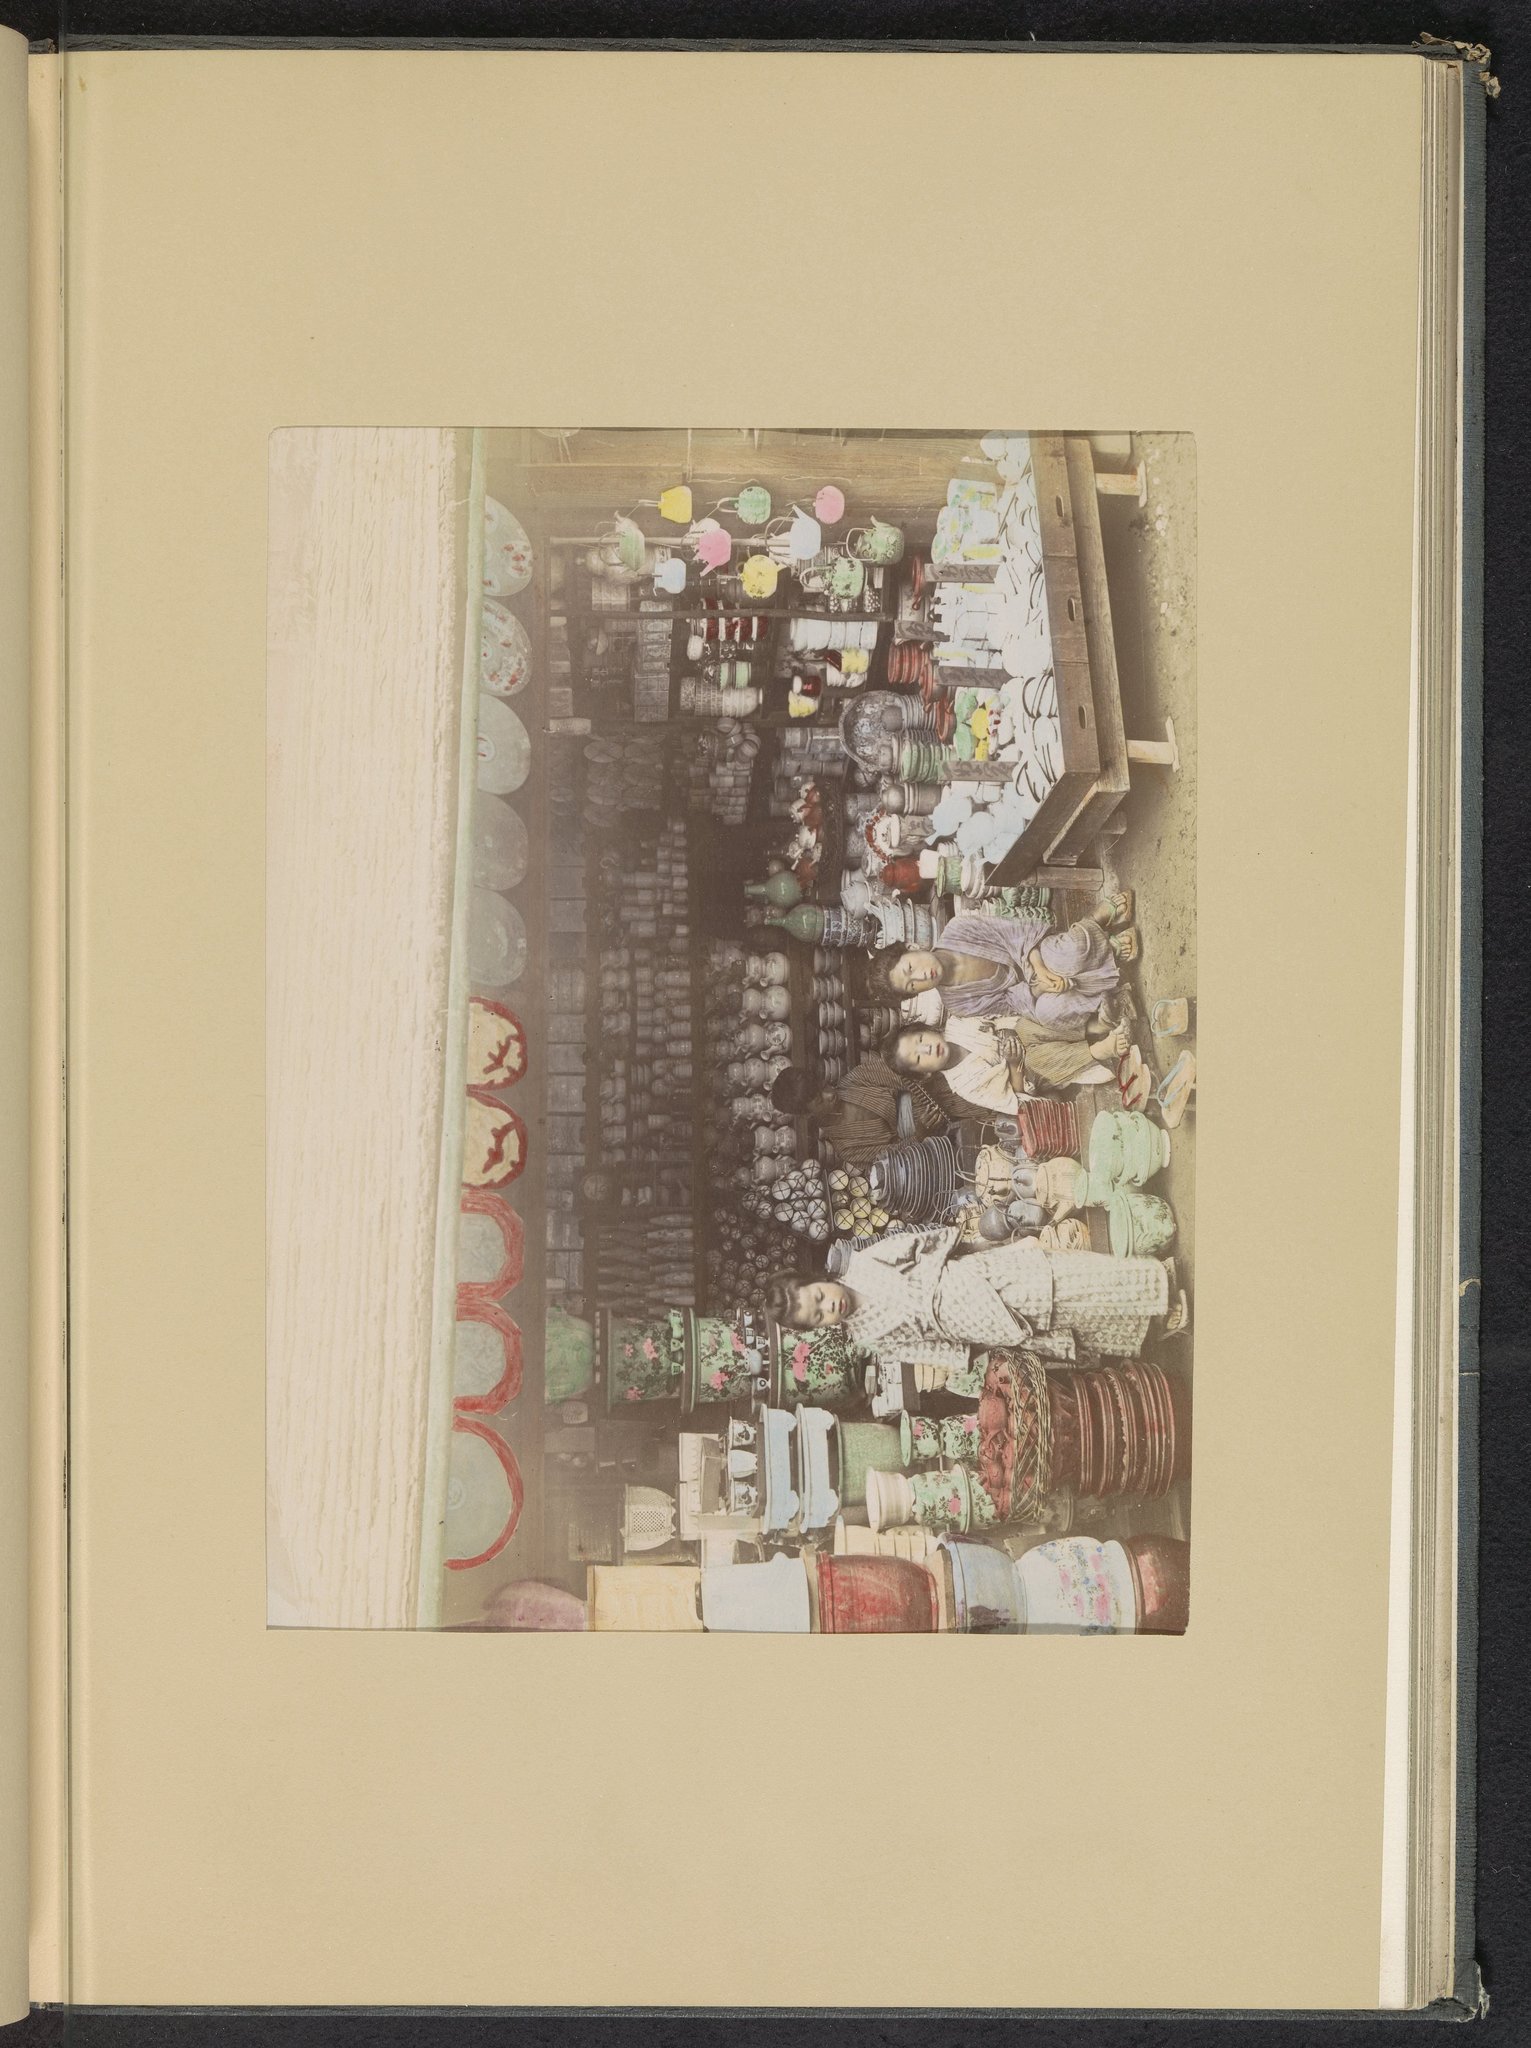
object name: photograph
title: Winkel met aardewerk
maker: Anonymous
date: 1887-1897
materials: photographic support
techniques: albumen print, hand coloring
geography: japan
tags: shop, store, container of ceramics: jar, jug, pot, vase